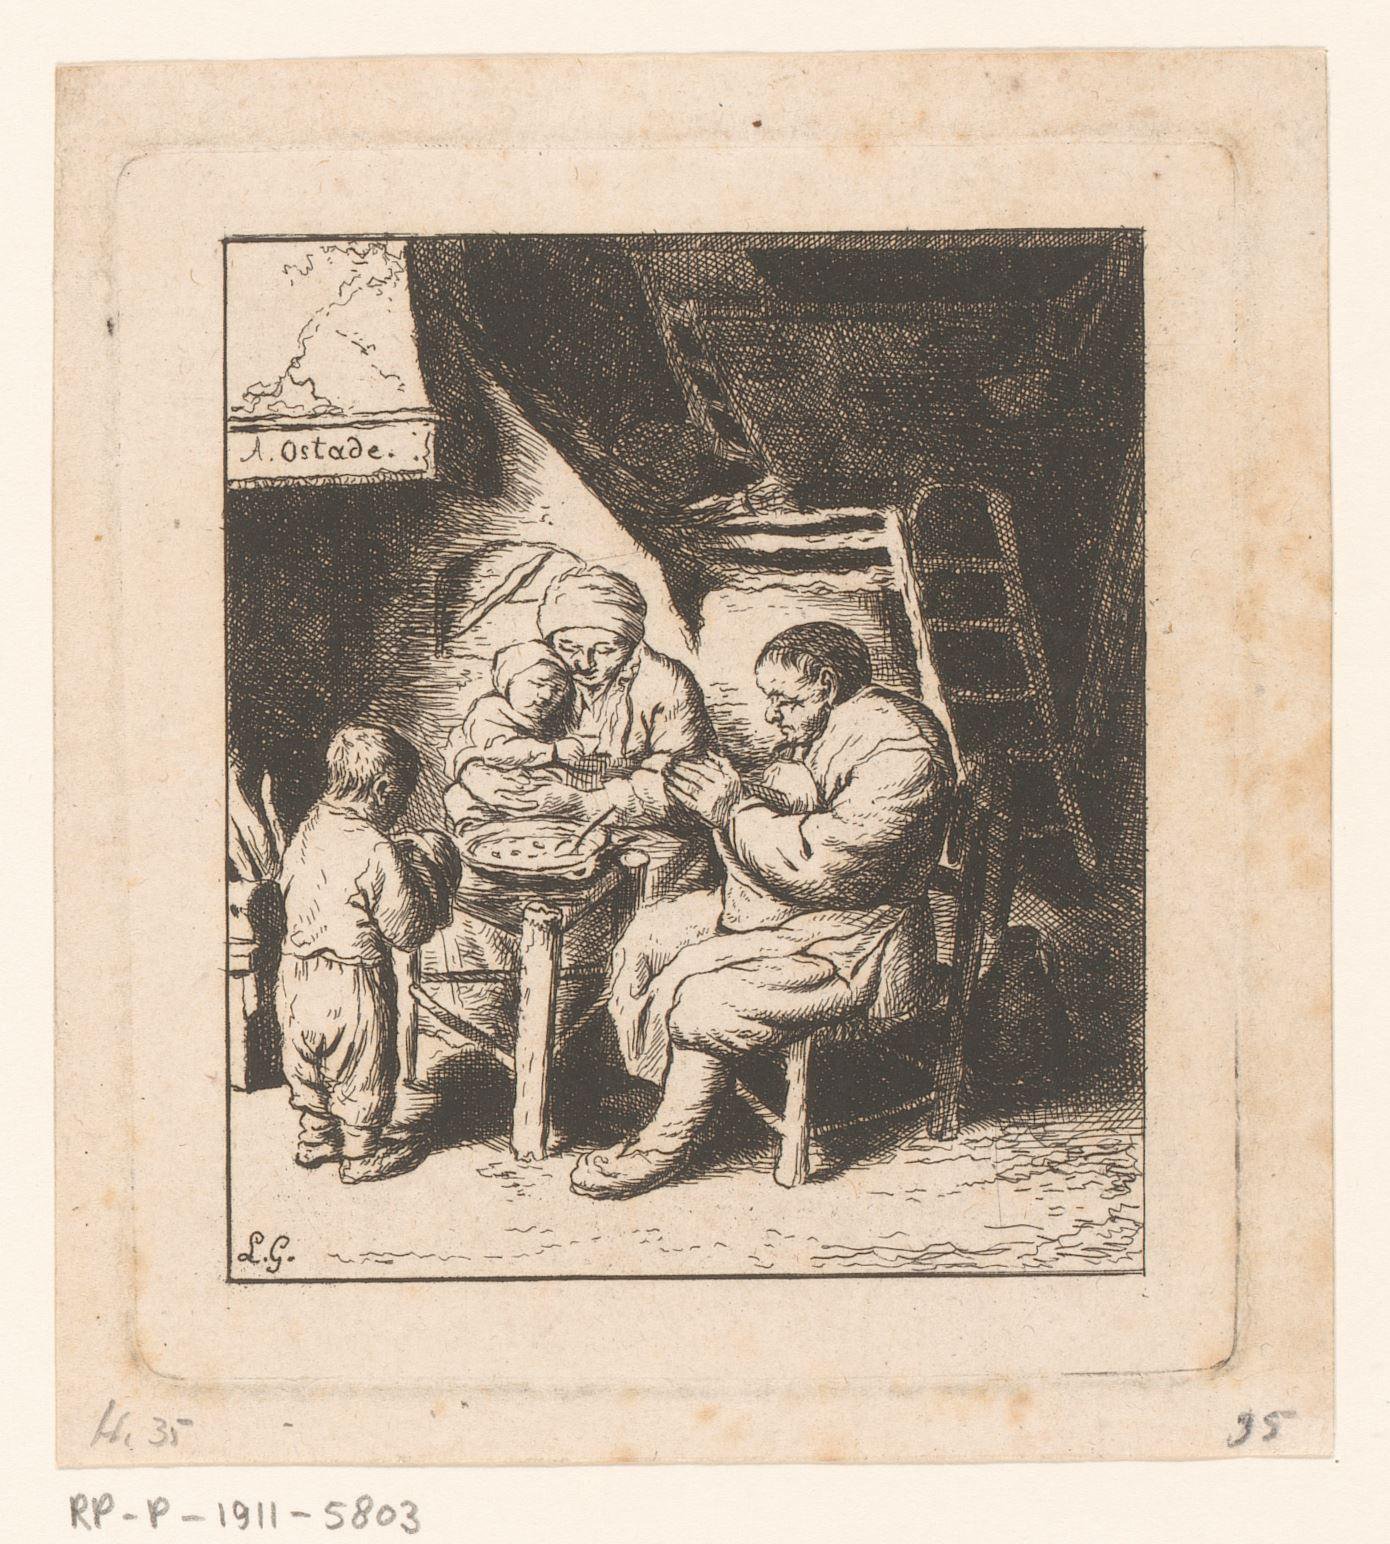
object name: print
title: Boerengezin aan de maaltijd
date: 1764-1834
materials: paper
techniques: etching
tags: evening meal, dinner, supper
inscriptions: collector's mark: Lugt 2228